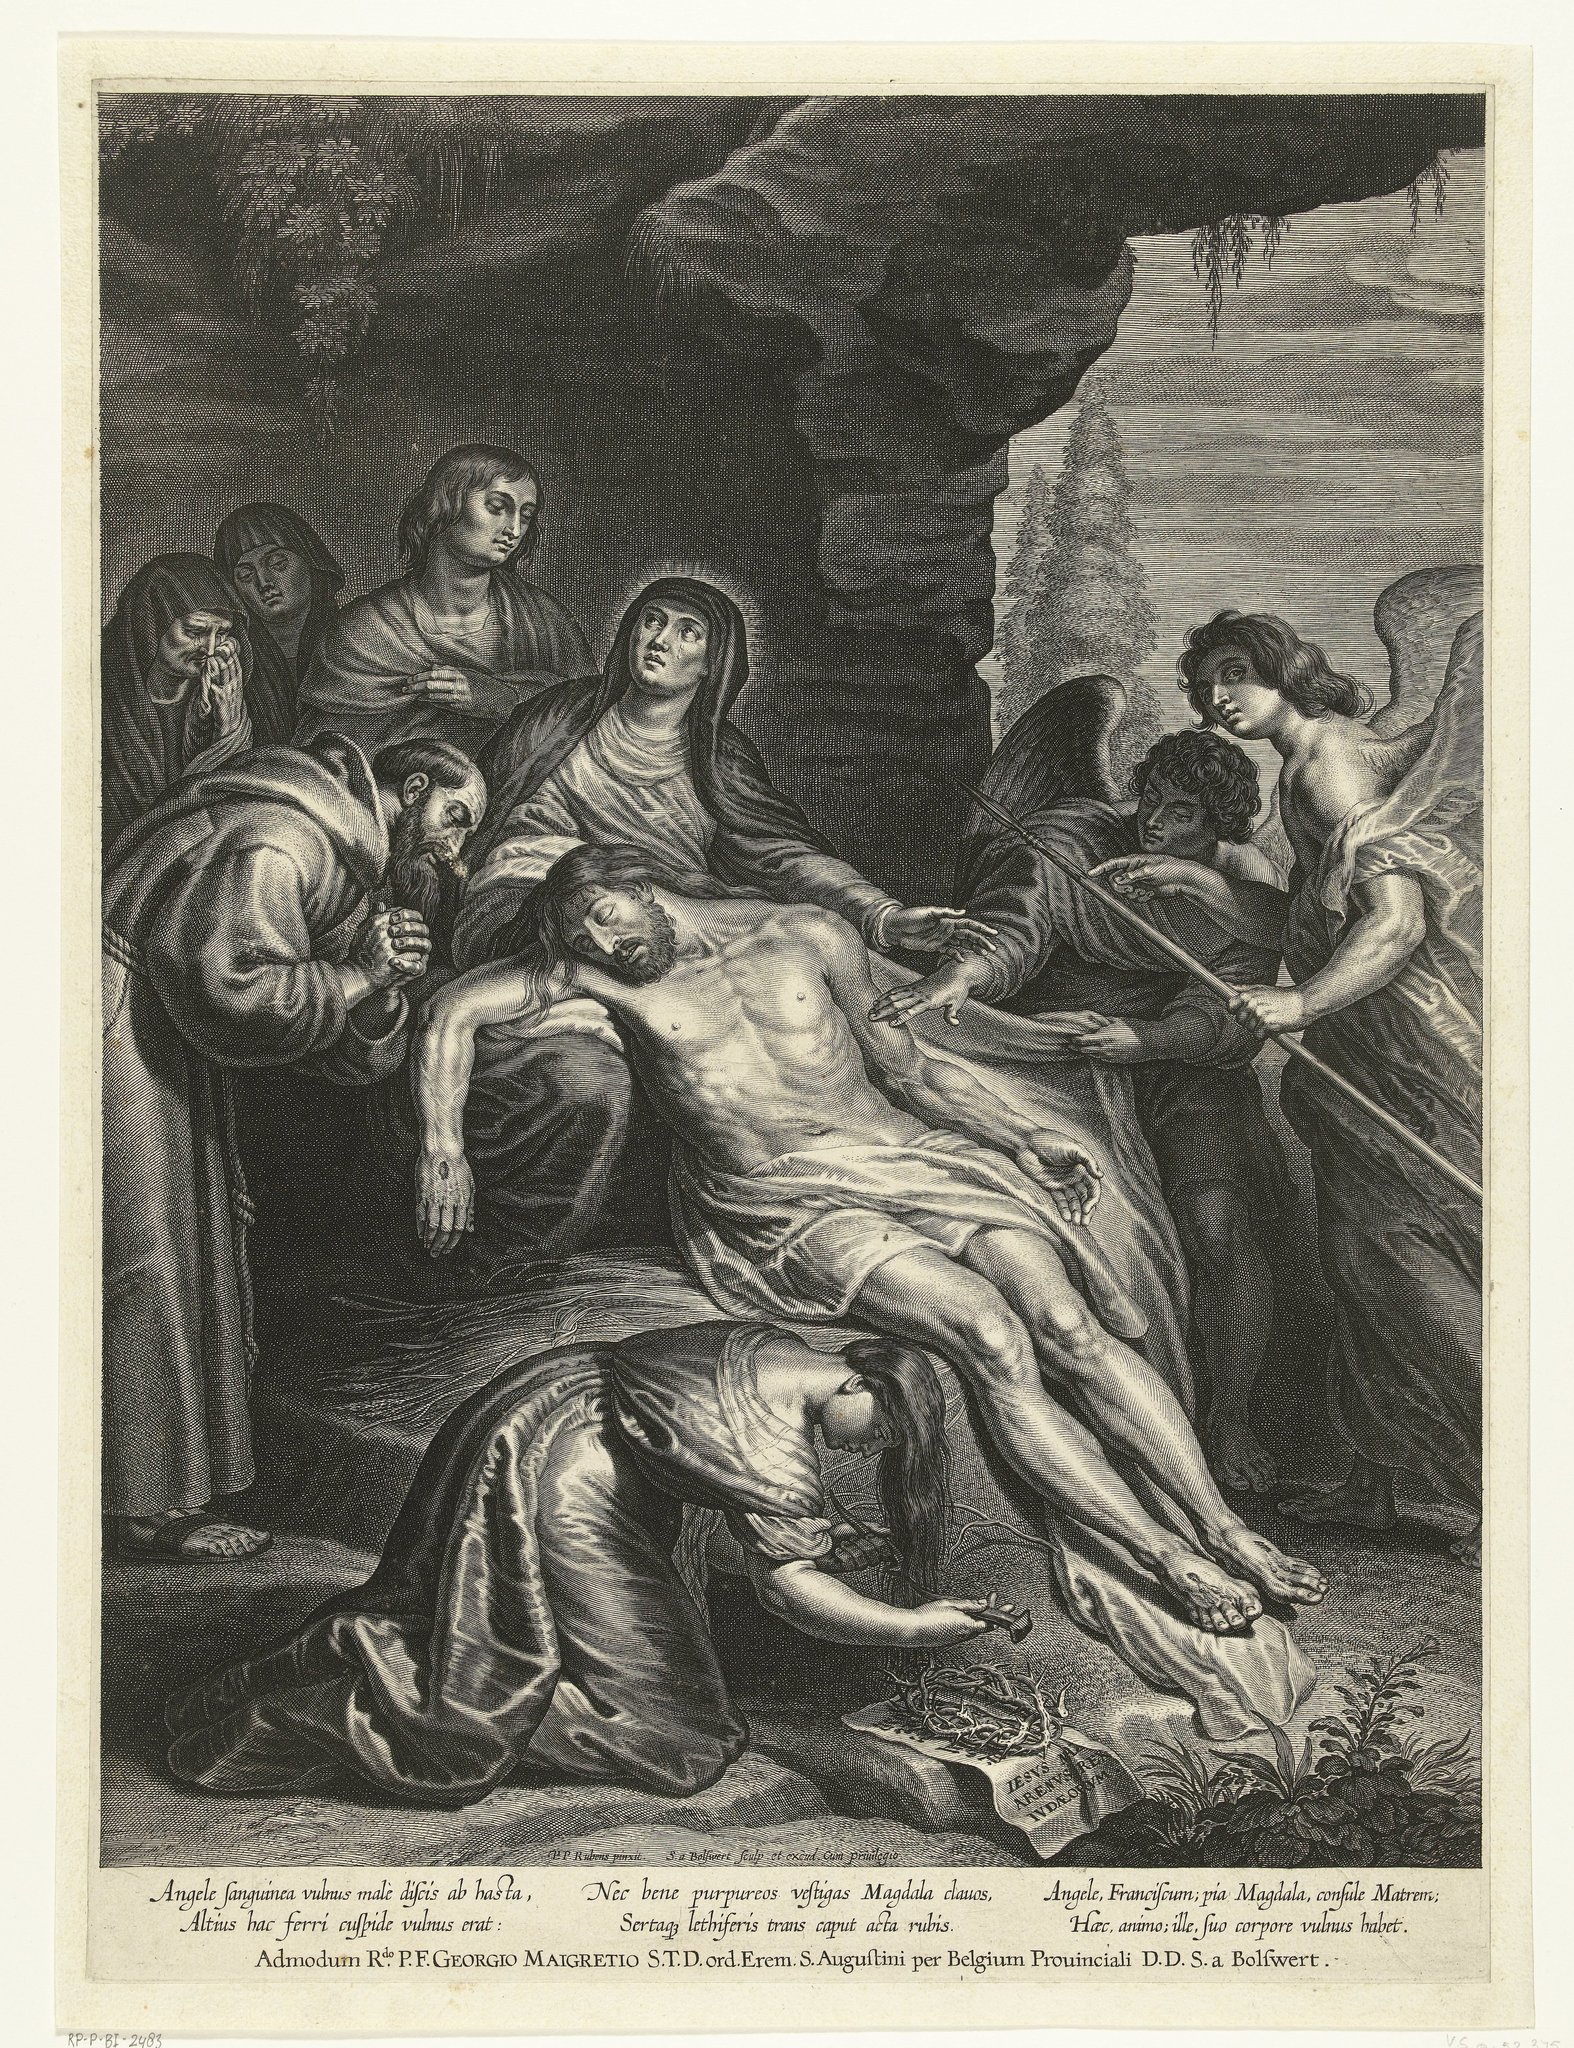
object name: print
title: Bewening van Christus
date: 1596-1659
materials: paper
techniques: engraving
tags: christ's body supported by mary, others present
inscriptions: collector's mark: Lugt 240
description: De bewening van dode lichaam van Christus door Maria, Maria Magdalena, Johannes en engelen in grot. Onder de voorstelling staat een Latijns vers.